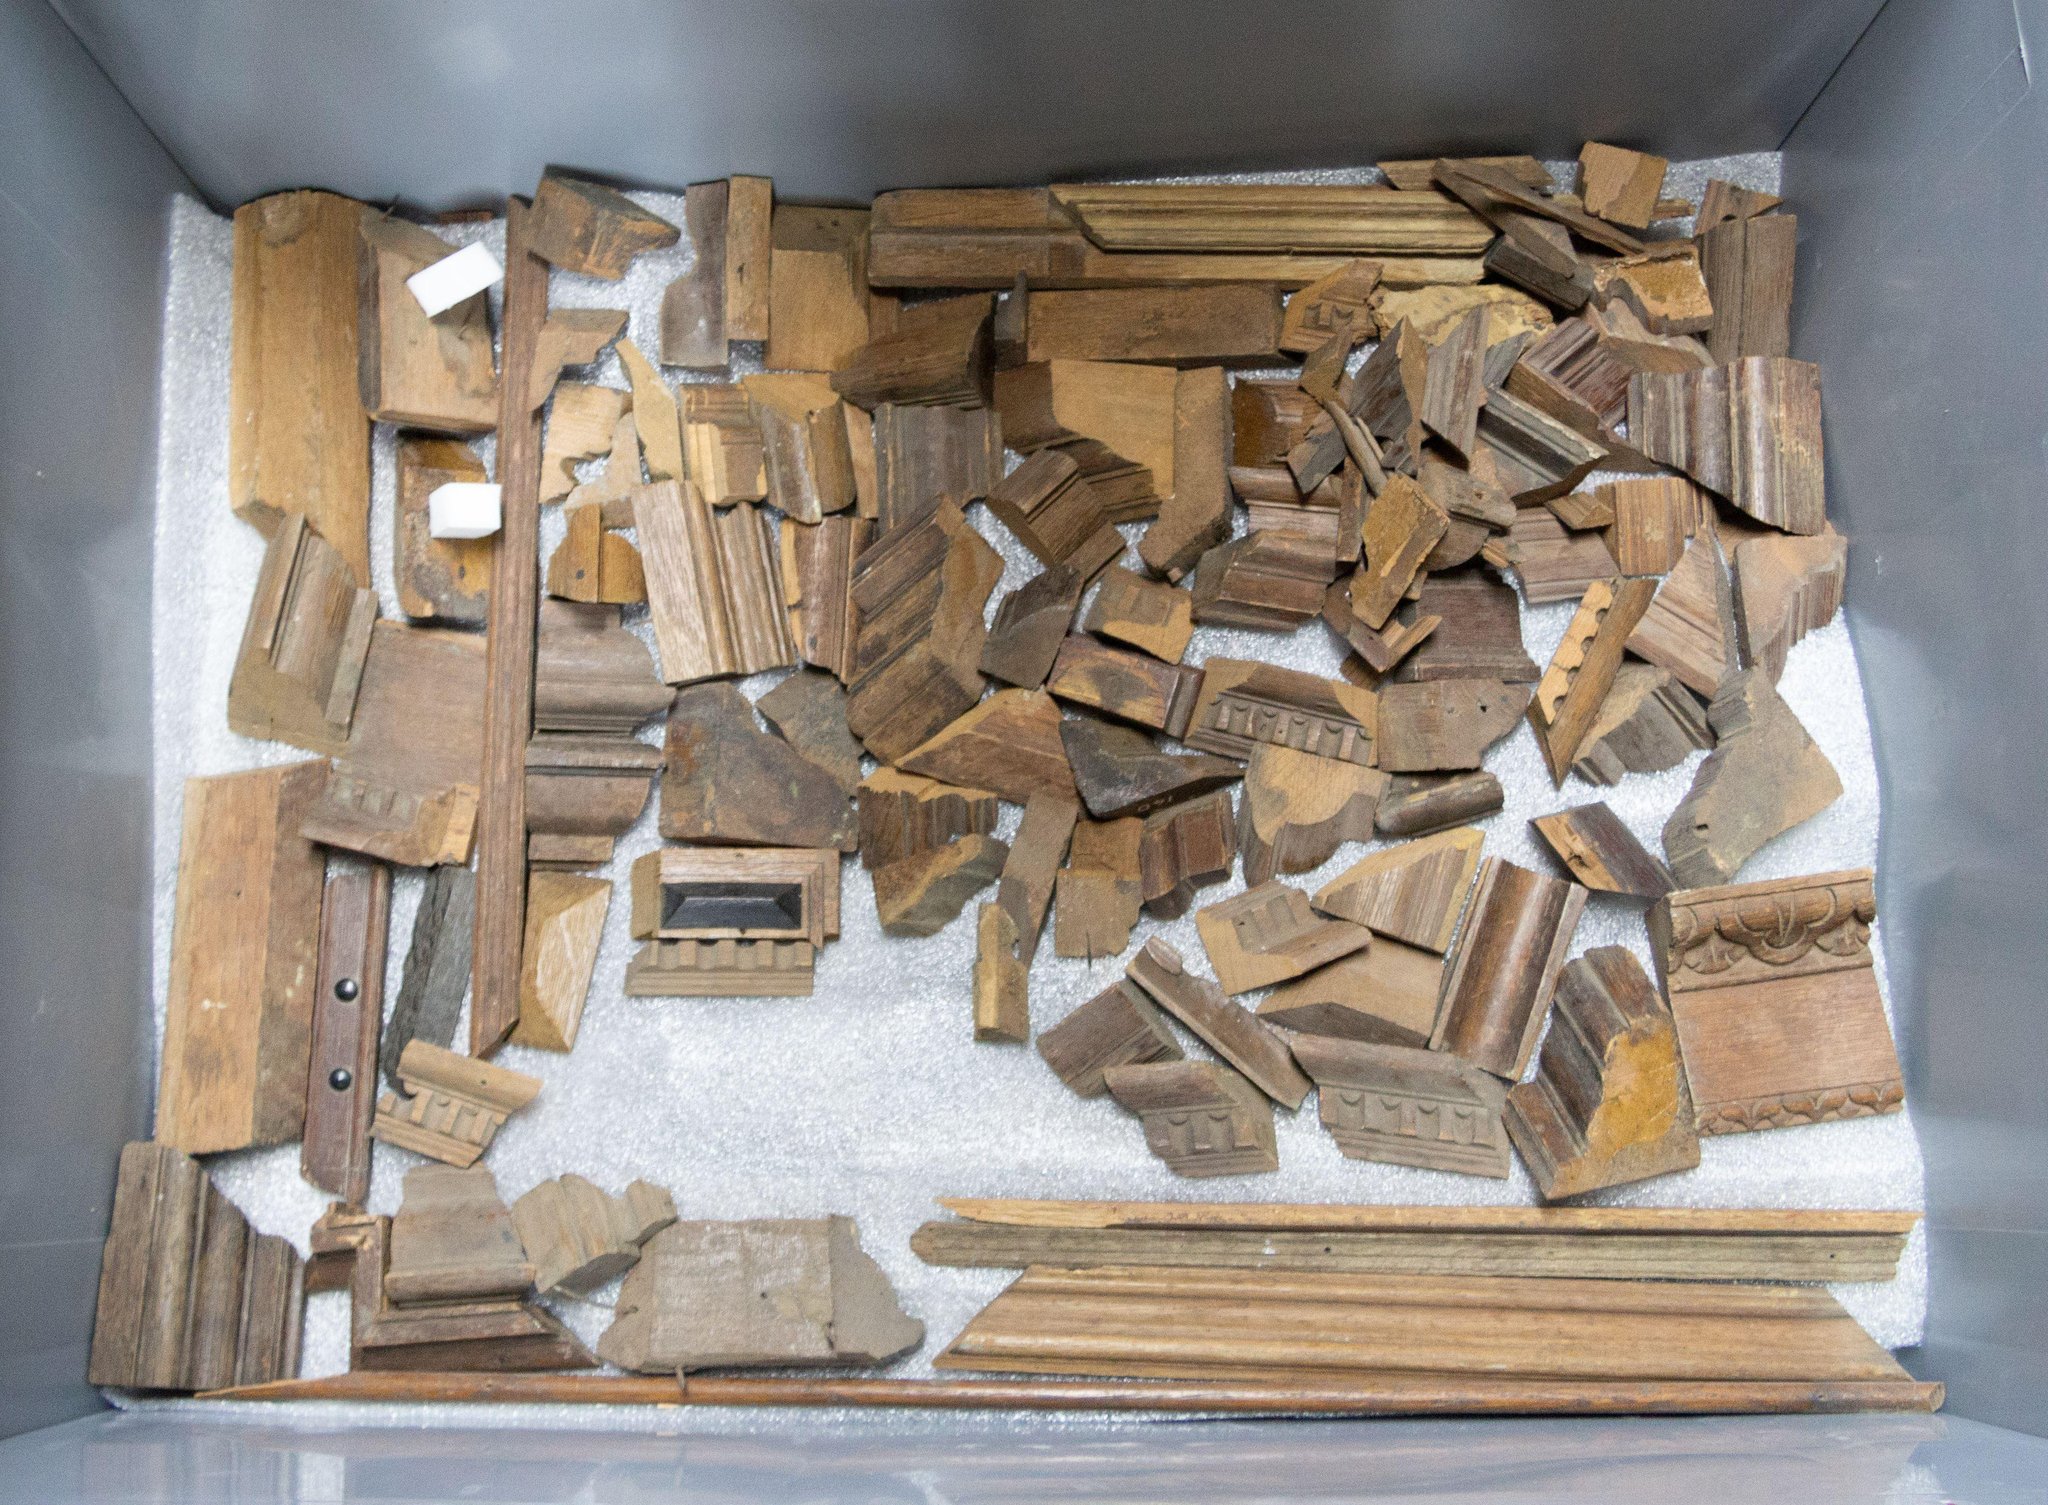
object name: betimmering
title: Verschillende onderdelen van een betimmering behorend bij een trap in vroege Marot-stijl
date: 1680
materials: wood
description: Verschillende onderdelen van een betimmering behorend bij een trap in vroege Marot-stijl.